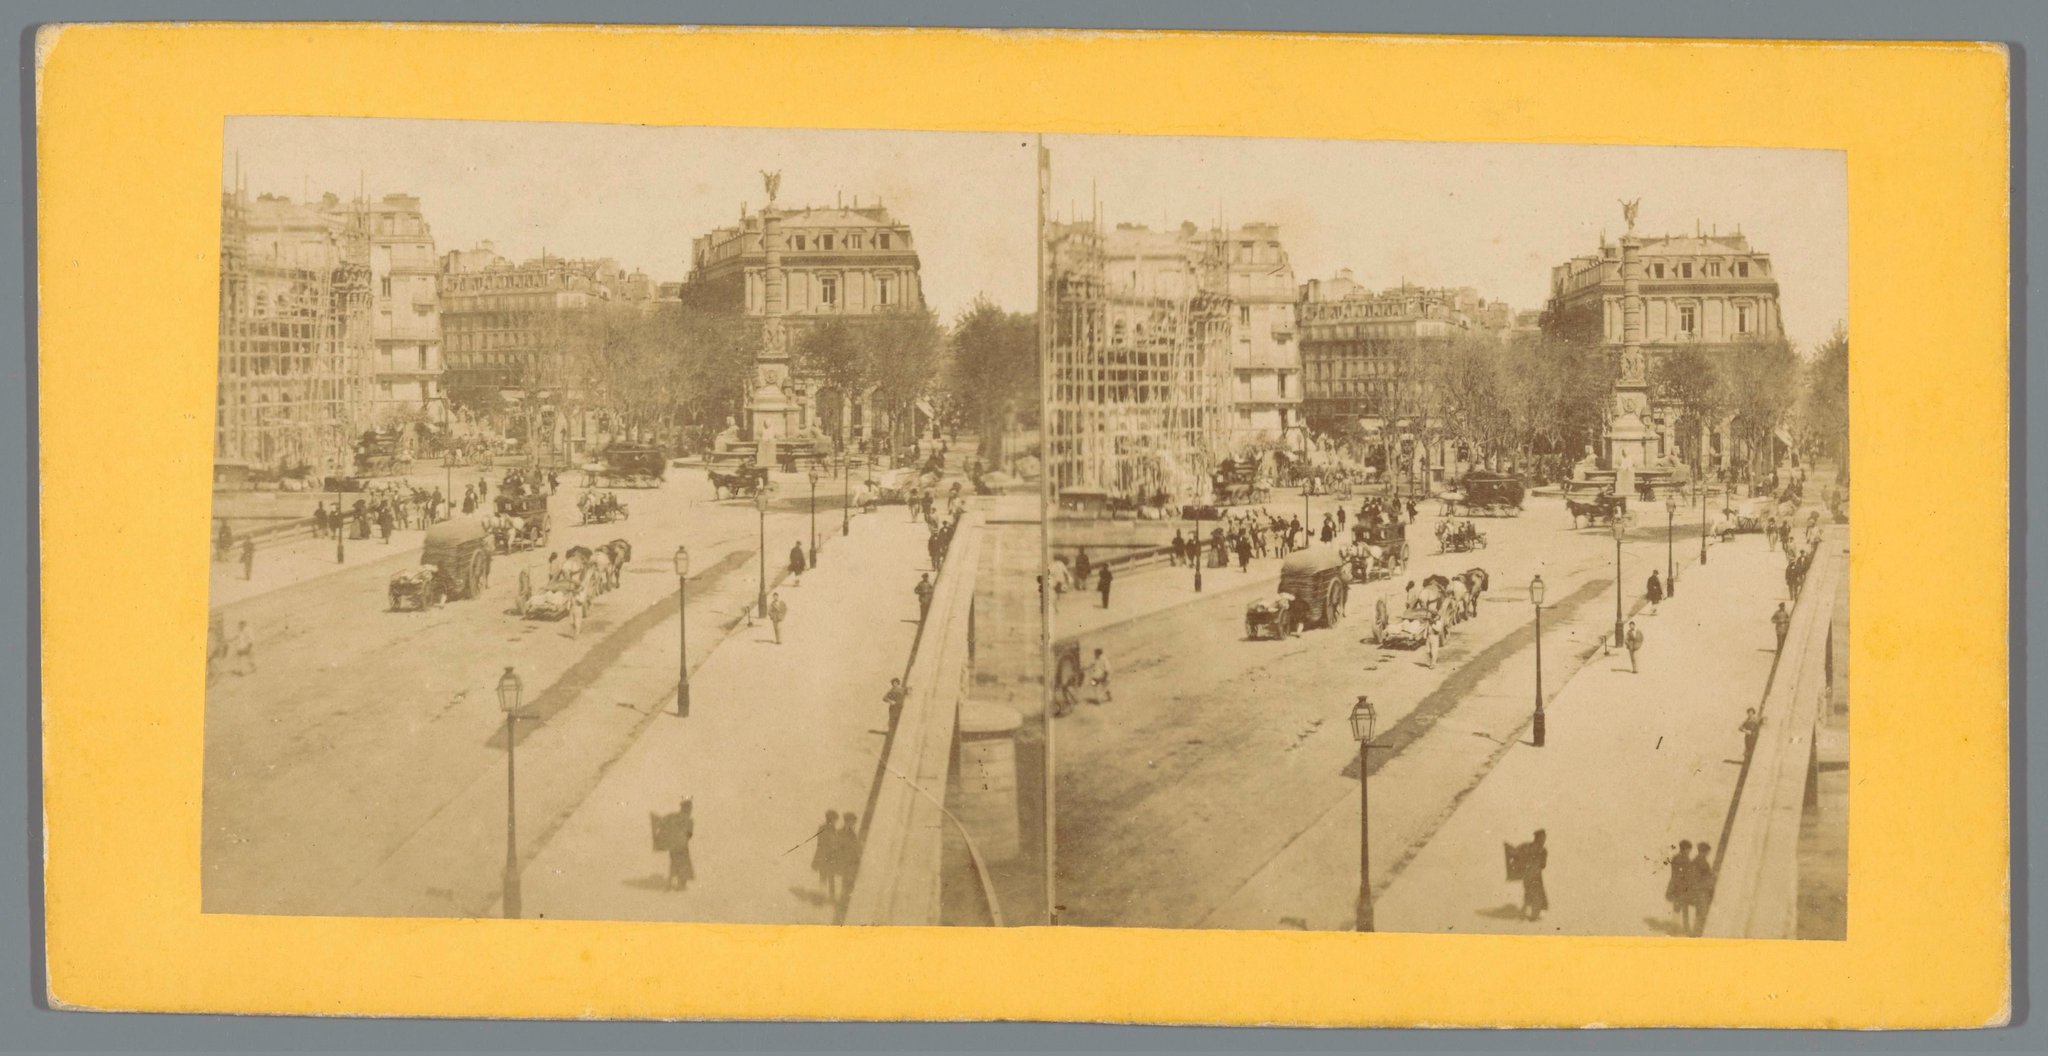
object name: stereograph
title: Gezicht op de Pont au Change en La Fontaine du Palmier in Parijs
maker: Anonymous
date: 1850-1880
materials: cardboard, photographic support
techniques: albumen print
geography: paris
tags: two-wheeled, animal-drawn vehicle, bridge in city across river, canal, etc.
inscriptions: inscription: ‘Pont au Change, Paris.’